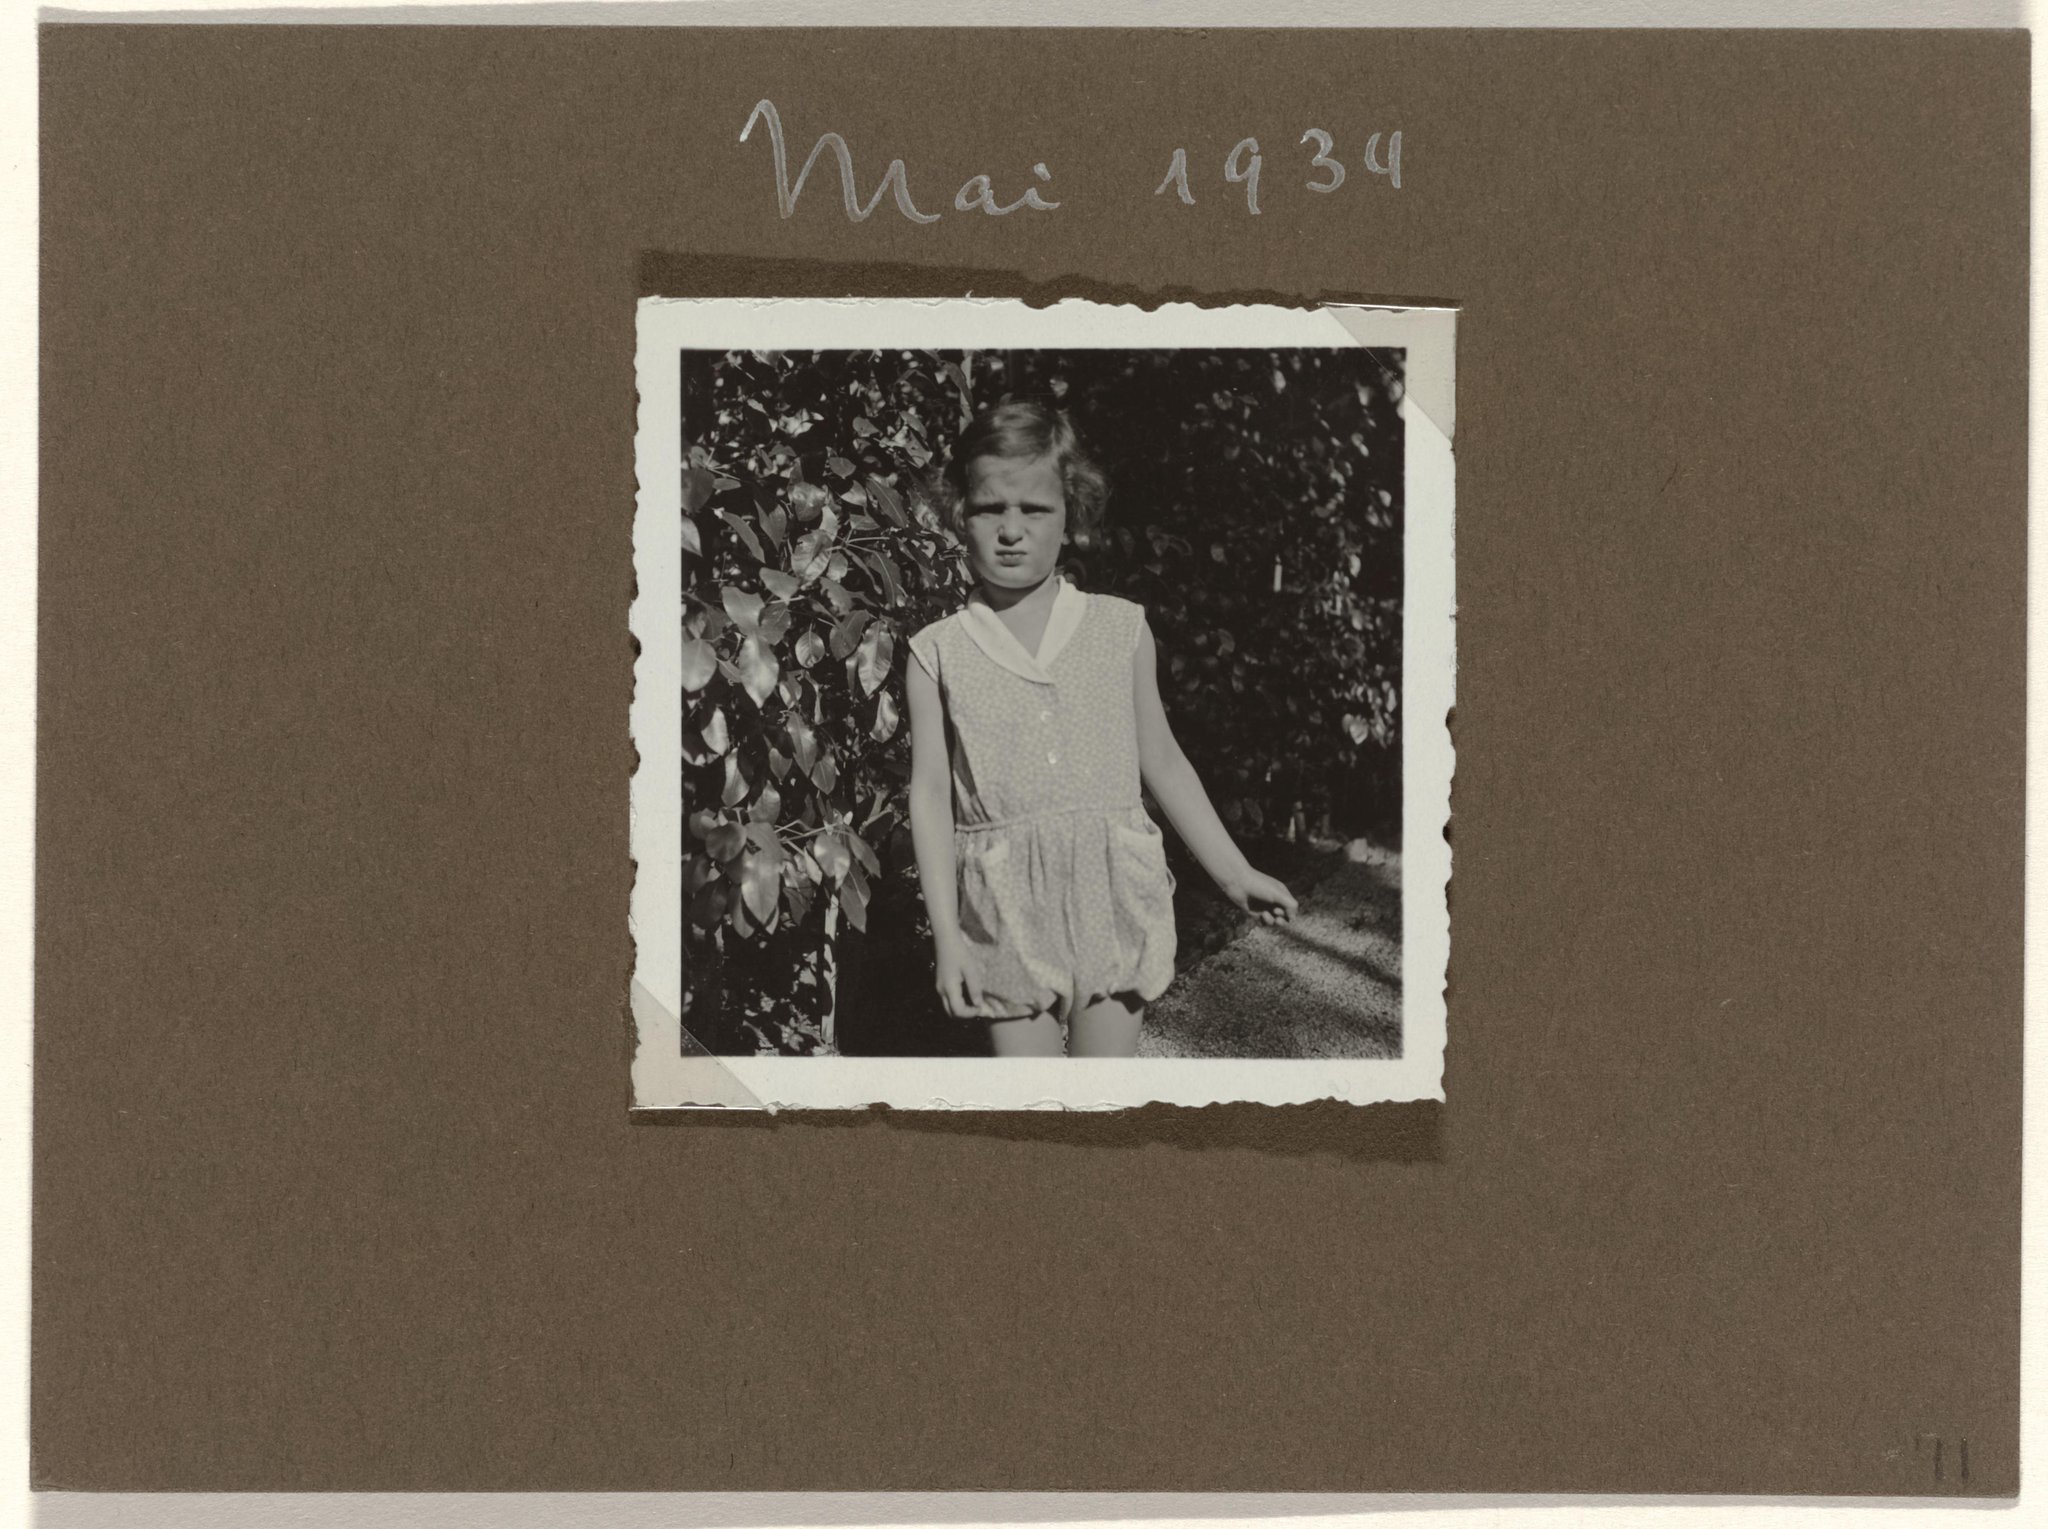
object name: photograph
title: Isabel Wachenheimer in een tuin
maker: Anonymous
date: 1905-1934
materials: photographic support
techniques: gelatin silver print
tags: leiden, isabel wachenheimer-elon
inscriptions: inscription: ‘Mai 1934’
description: Dit object is onderdeel van de nalatenschap van Isabel Elon-Wachenheimer (1928-2010). Tot haar overlijden behoorde het samen met de andere objecten uit de nalatenschap tot haar privédomein van Isabel Wachenheimer. In die particuliere context zijn deze objecten tezamen en individueel aandenkens - aan de jeugd, ouders en familie van Isabel Wachenheimer vóór en tijdens de Shoah en aan haar leven na de Tweede Wereldoorlog. Isabel Wachenheimer, die van juni 1943 tot mei 1945 gevangen zat in Kamp Westerbork, Theresienstadt, Auschwitz, Lenzing a/d Oberdonau (een buitenkamp van Mauthausen), overleefde de Shoah. Haar ouders – Eugène Wachenheimer en Else Wachenheimer-Moos - werden op 14 oktober 1944 in Auschwitz-Birkenau vermoord.